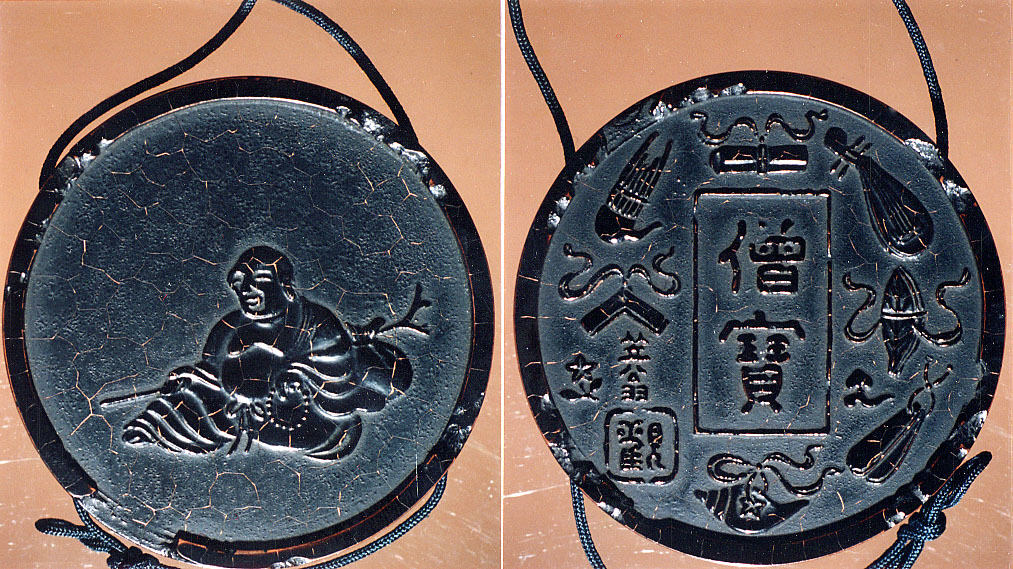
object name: inrō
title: Case (Inrō) in the Shape of an Ink Stick with Design of Hotei (Putai) (obverse); Musical Instruments (reverse)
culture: japanese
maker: shibata zeshin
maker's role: artist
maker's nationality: japanese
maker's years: 1807-1891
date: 1801-1900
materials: lacquer, stone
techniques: carving, hiramakie, polish, relief, roiro, maki-e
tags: musical instruments,men